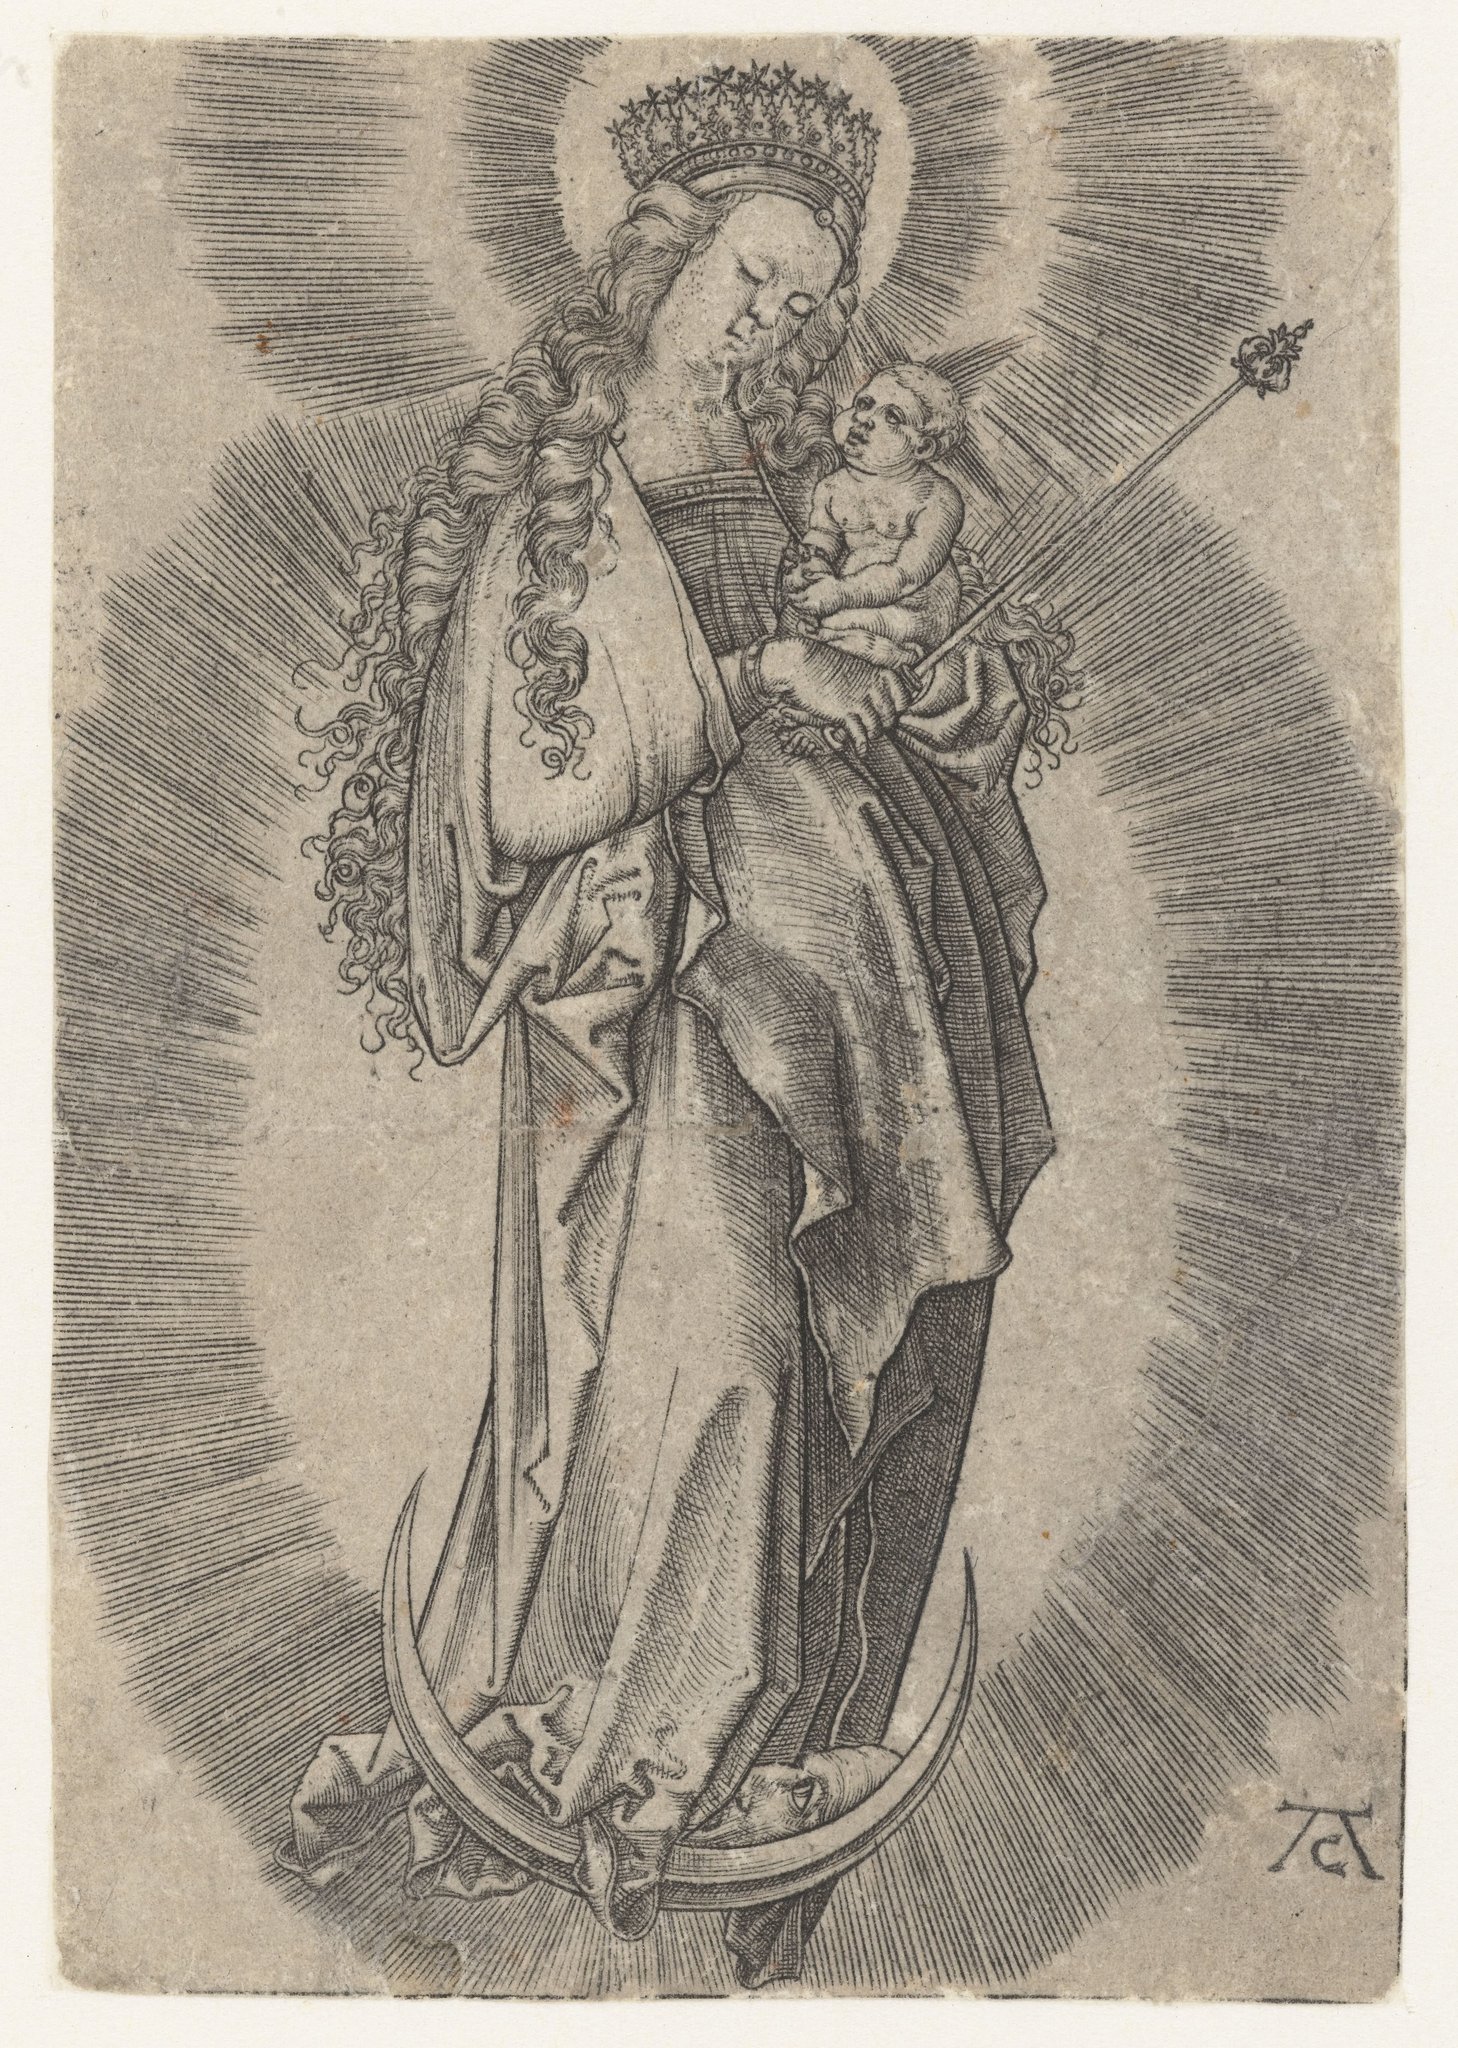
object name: print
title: Madonna op de maansikkel.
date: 1520-1562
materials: paper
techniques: engraving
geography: low countries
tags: madonna on the crescent of the moon (sometimes called queen of heaven) (in mandorla)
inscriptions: collector's mark: Lugt 2228a, collector's mark: Lugt 240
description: Gekroonde Maria met Christuskind op de maansikkel omringd door stralenkrans.